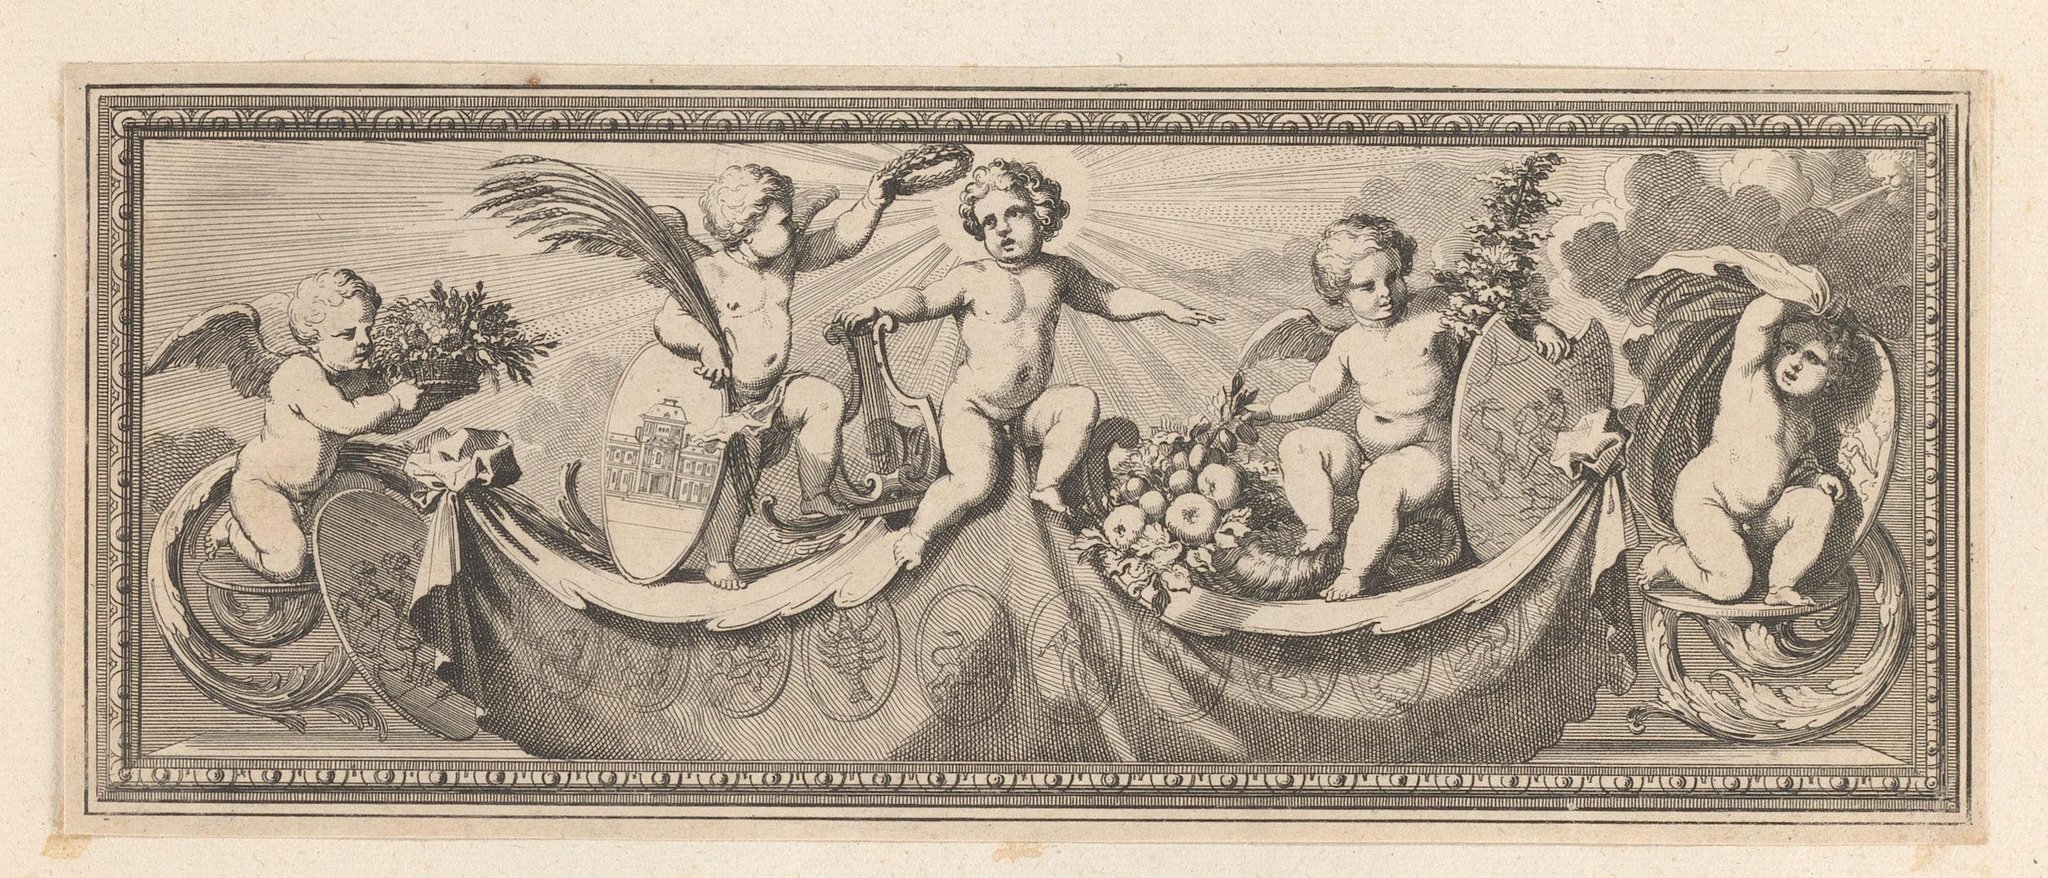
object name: print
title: Vignet met putti de jaargetijden verbeeldend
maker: sébastien leclerc (i)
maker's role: print maker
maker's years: 1637-1714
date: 1670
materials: paper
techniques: engraving, etching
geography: paris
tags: year divided into four seasons, vignette, cupids: 'amores', 'amoretti', 'putti'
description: Prent uit: Félibien, André. Tapisseries du Roi, où sont représentez les quatre élémens et les quatre saisons. Parijs: Imprimerie Royale, 1670.